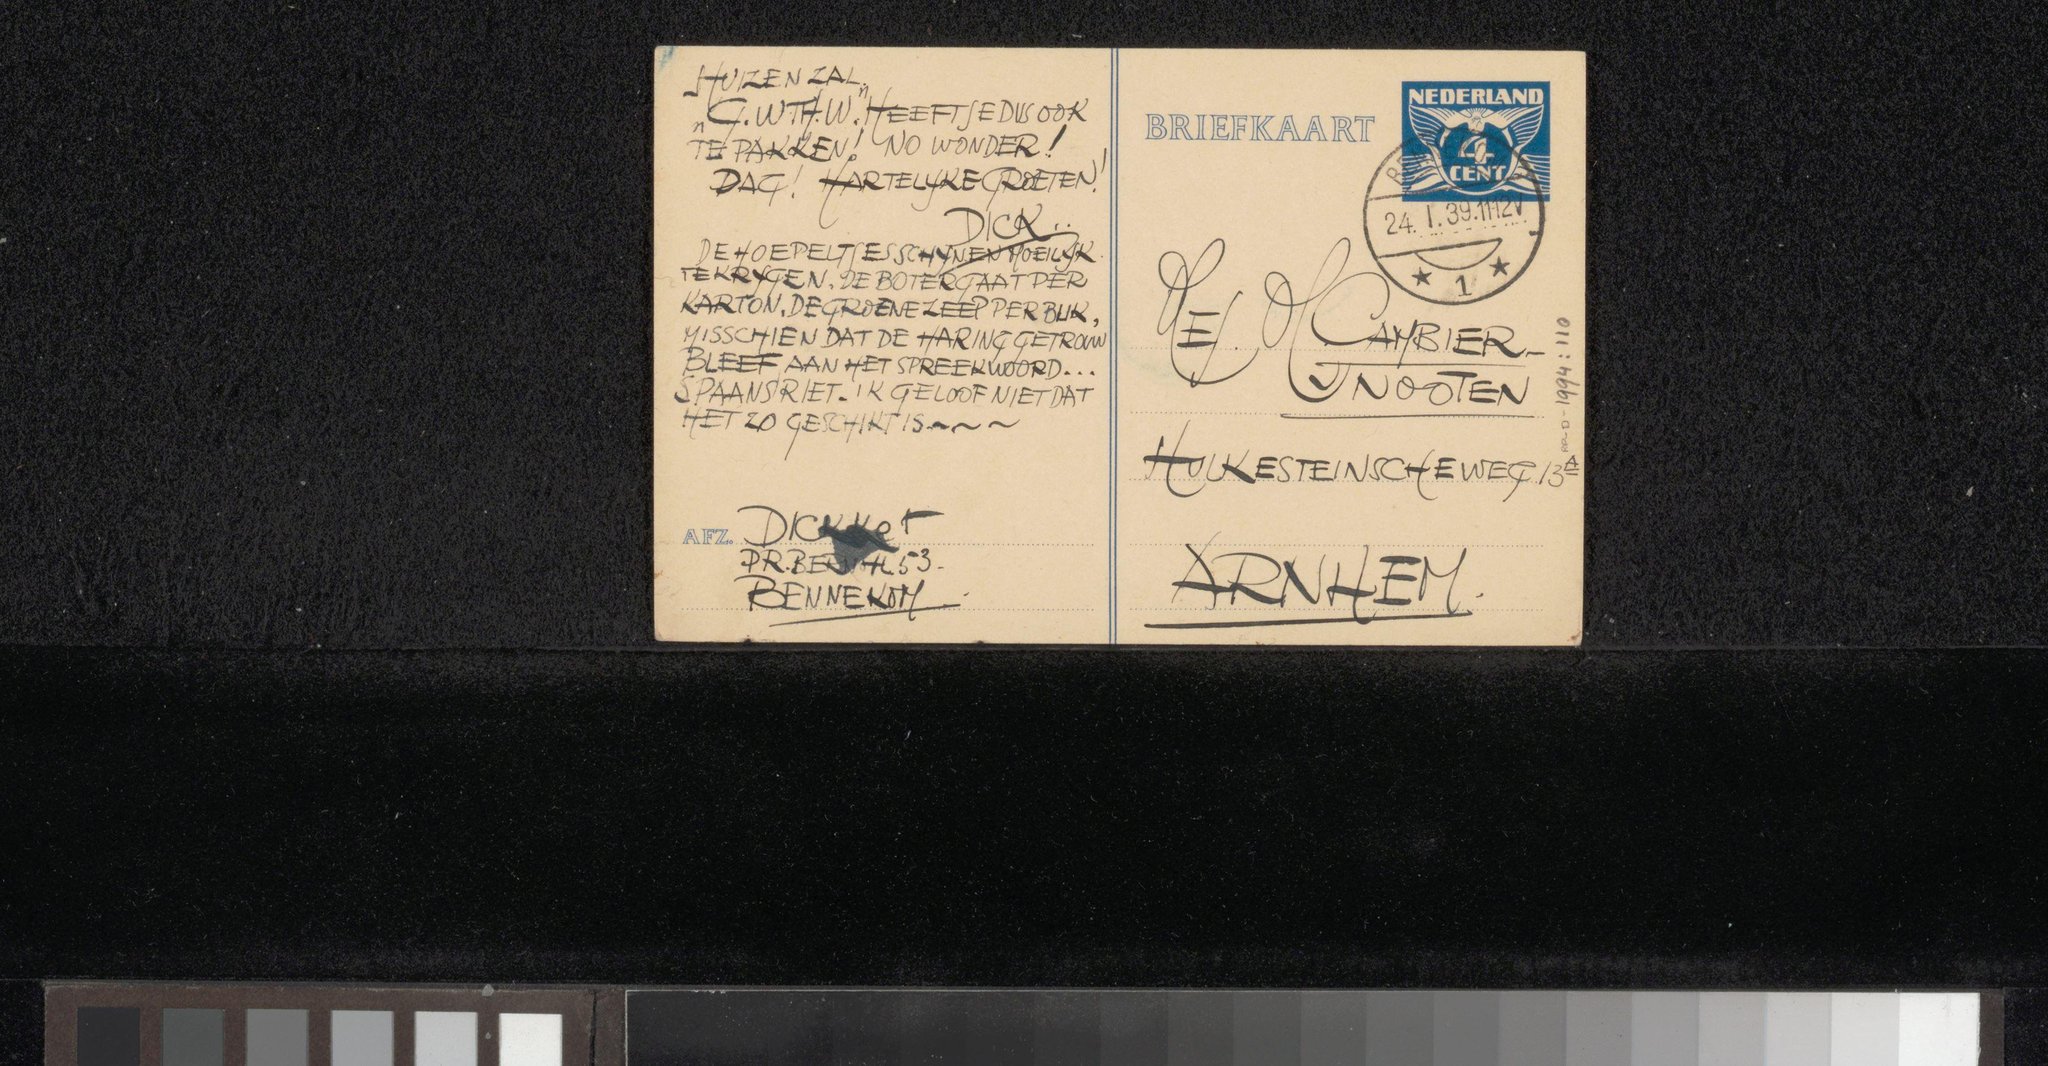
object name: postcard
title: Briefkaart aan Mien Cambier van Nooten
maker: dick ket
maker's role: draughtsman, print maker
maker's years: 1902-1940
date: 1939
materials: cardboard, ink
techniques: pen, writing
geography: bennekom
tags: grave, arnhem, mien cambier van nooten, joep nicolas, drawing, painting (including book-illumination, miniature-painting), exhibition ~ art, historical persons (portraits and scenes from the life)